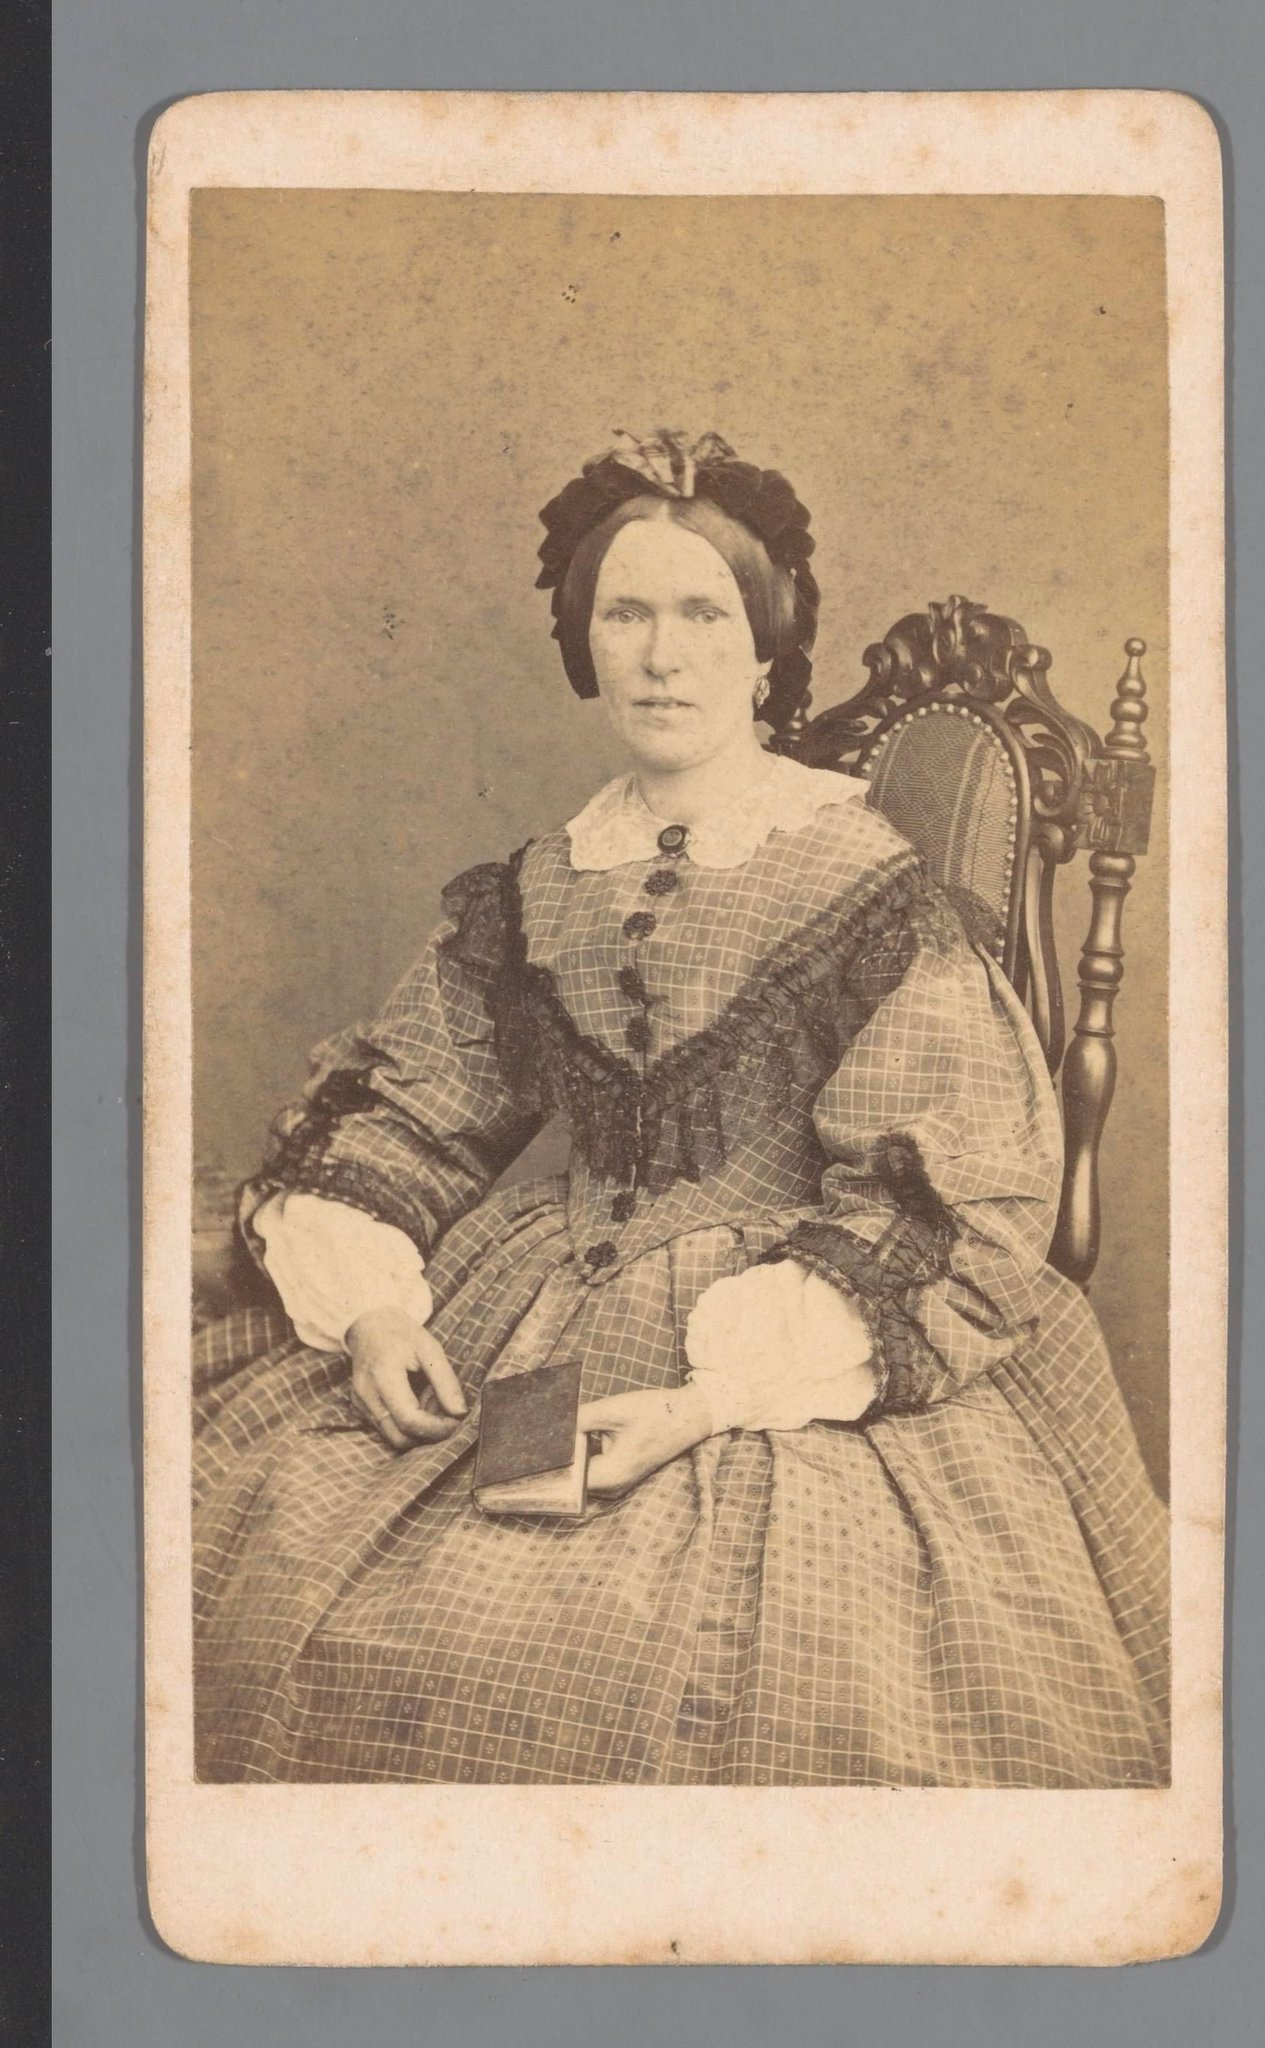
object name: carte de visite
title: Portret van Martha Cornelia Blok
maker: Anonymous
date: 1850-1867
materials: cardboard, photographic support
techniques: albumen print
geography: netherlands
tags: historical persons - bb - woman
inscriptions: annotation: ‘7640 / 12 copies’, annotation: ‘Martha CorneliA / Oma Trip- / Blok’